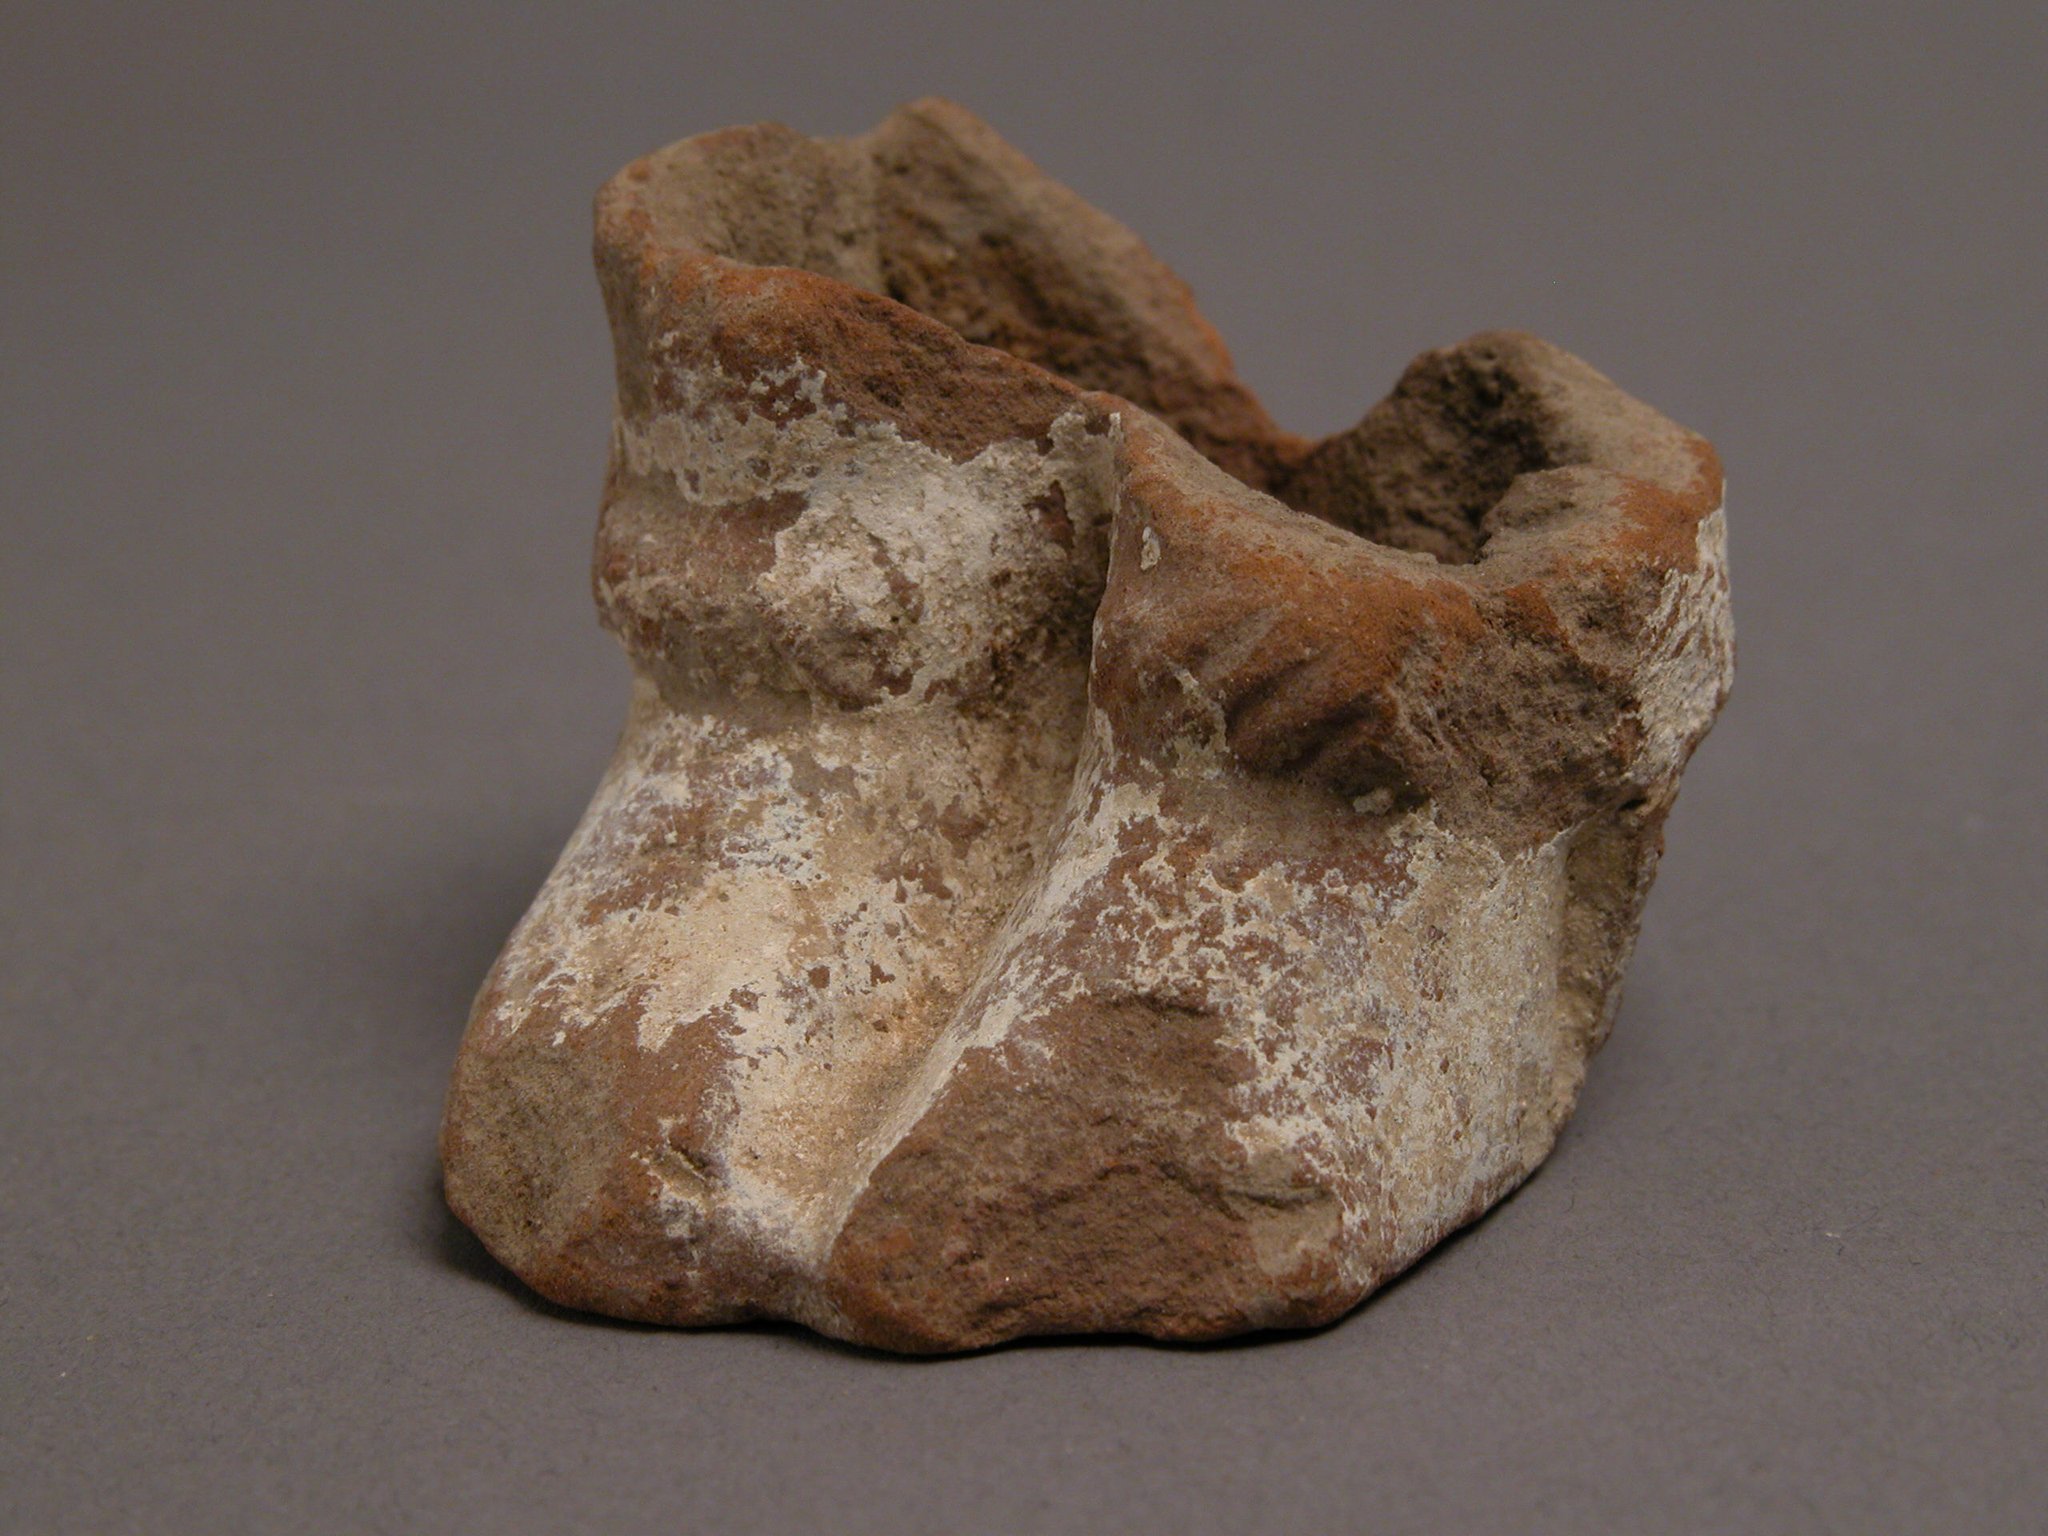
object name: statuette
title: Feet Fragment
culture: coptic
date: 301-700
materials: earthenware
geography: egypt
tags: feet